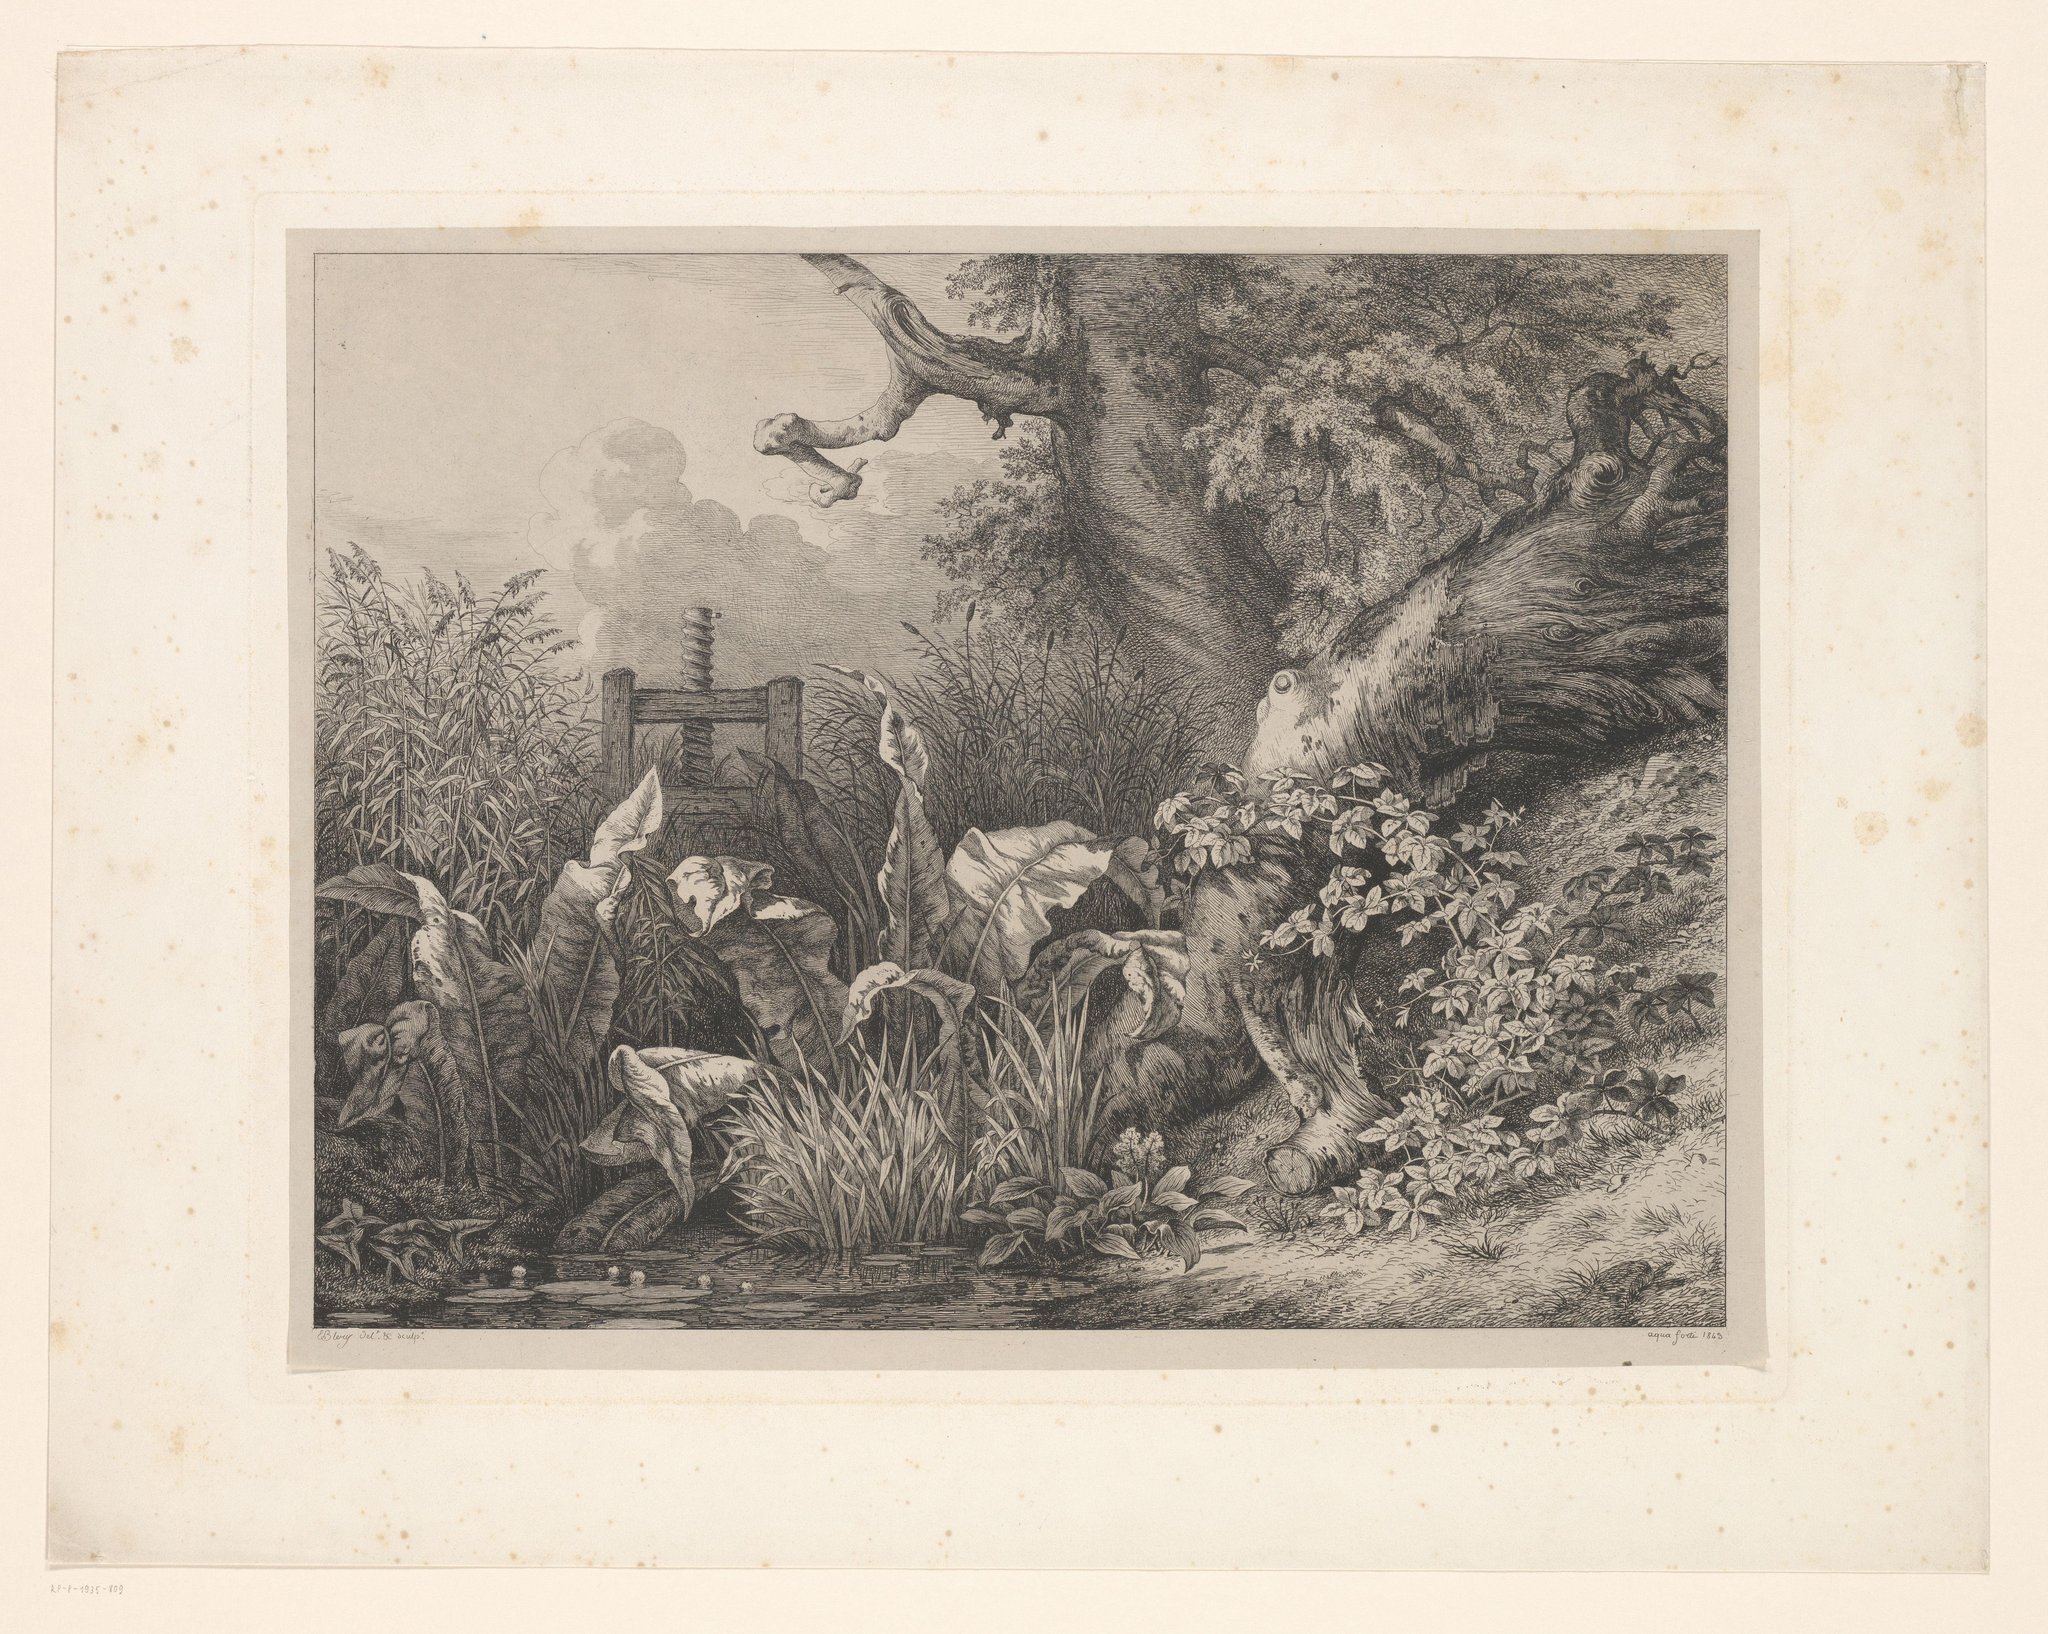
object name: print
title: La patience d'eau et la ronce à la vanne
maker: eugène bléry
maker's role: print maker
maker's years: 1805-1887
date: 1843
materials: paper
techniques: aquatint, engraving, etching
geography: france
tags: plants (in general), pond, pool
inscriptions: collector's mark: Lugt 2228